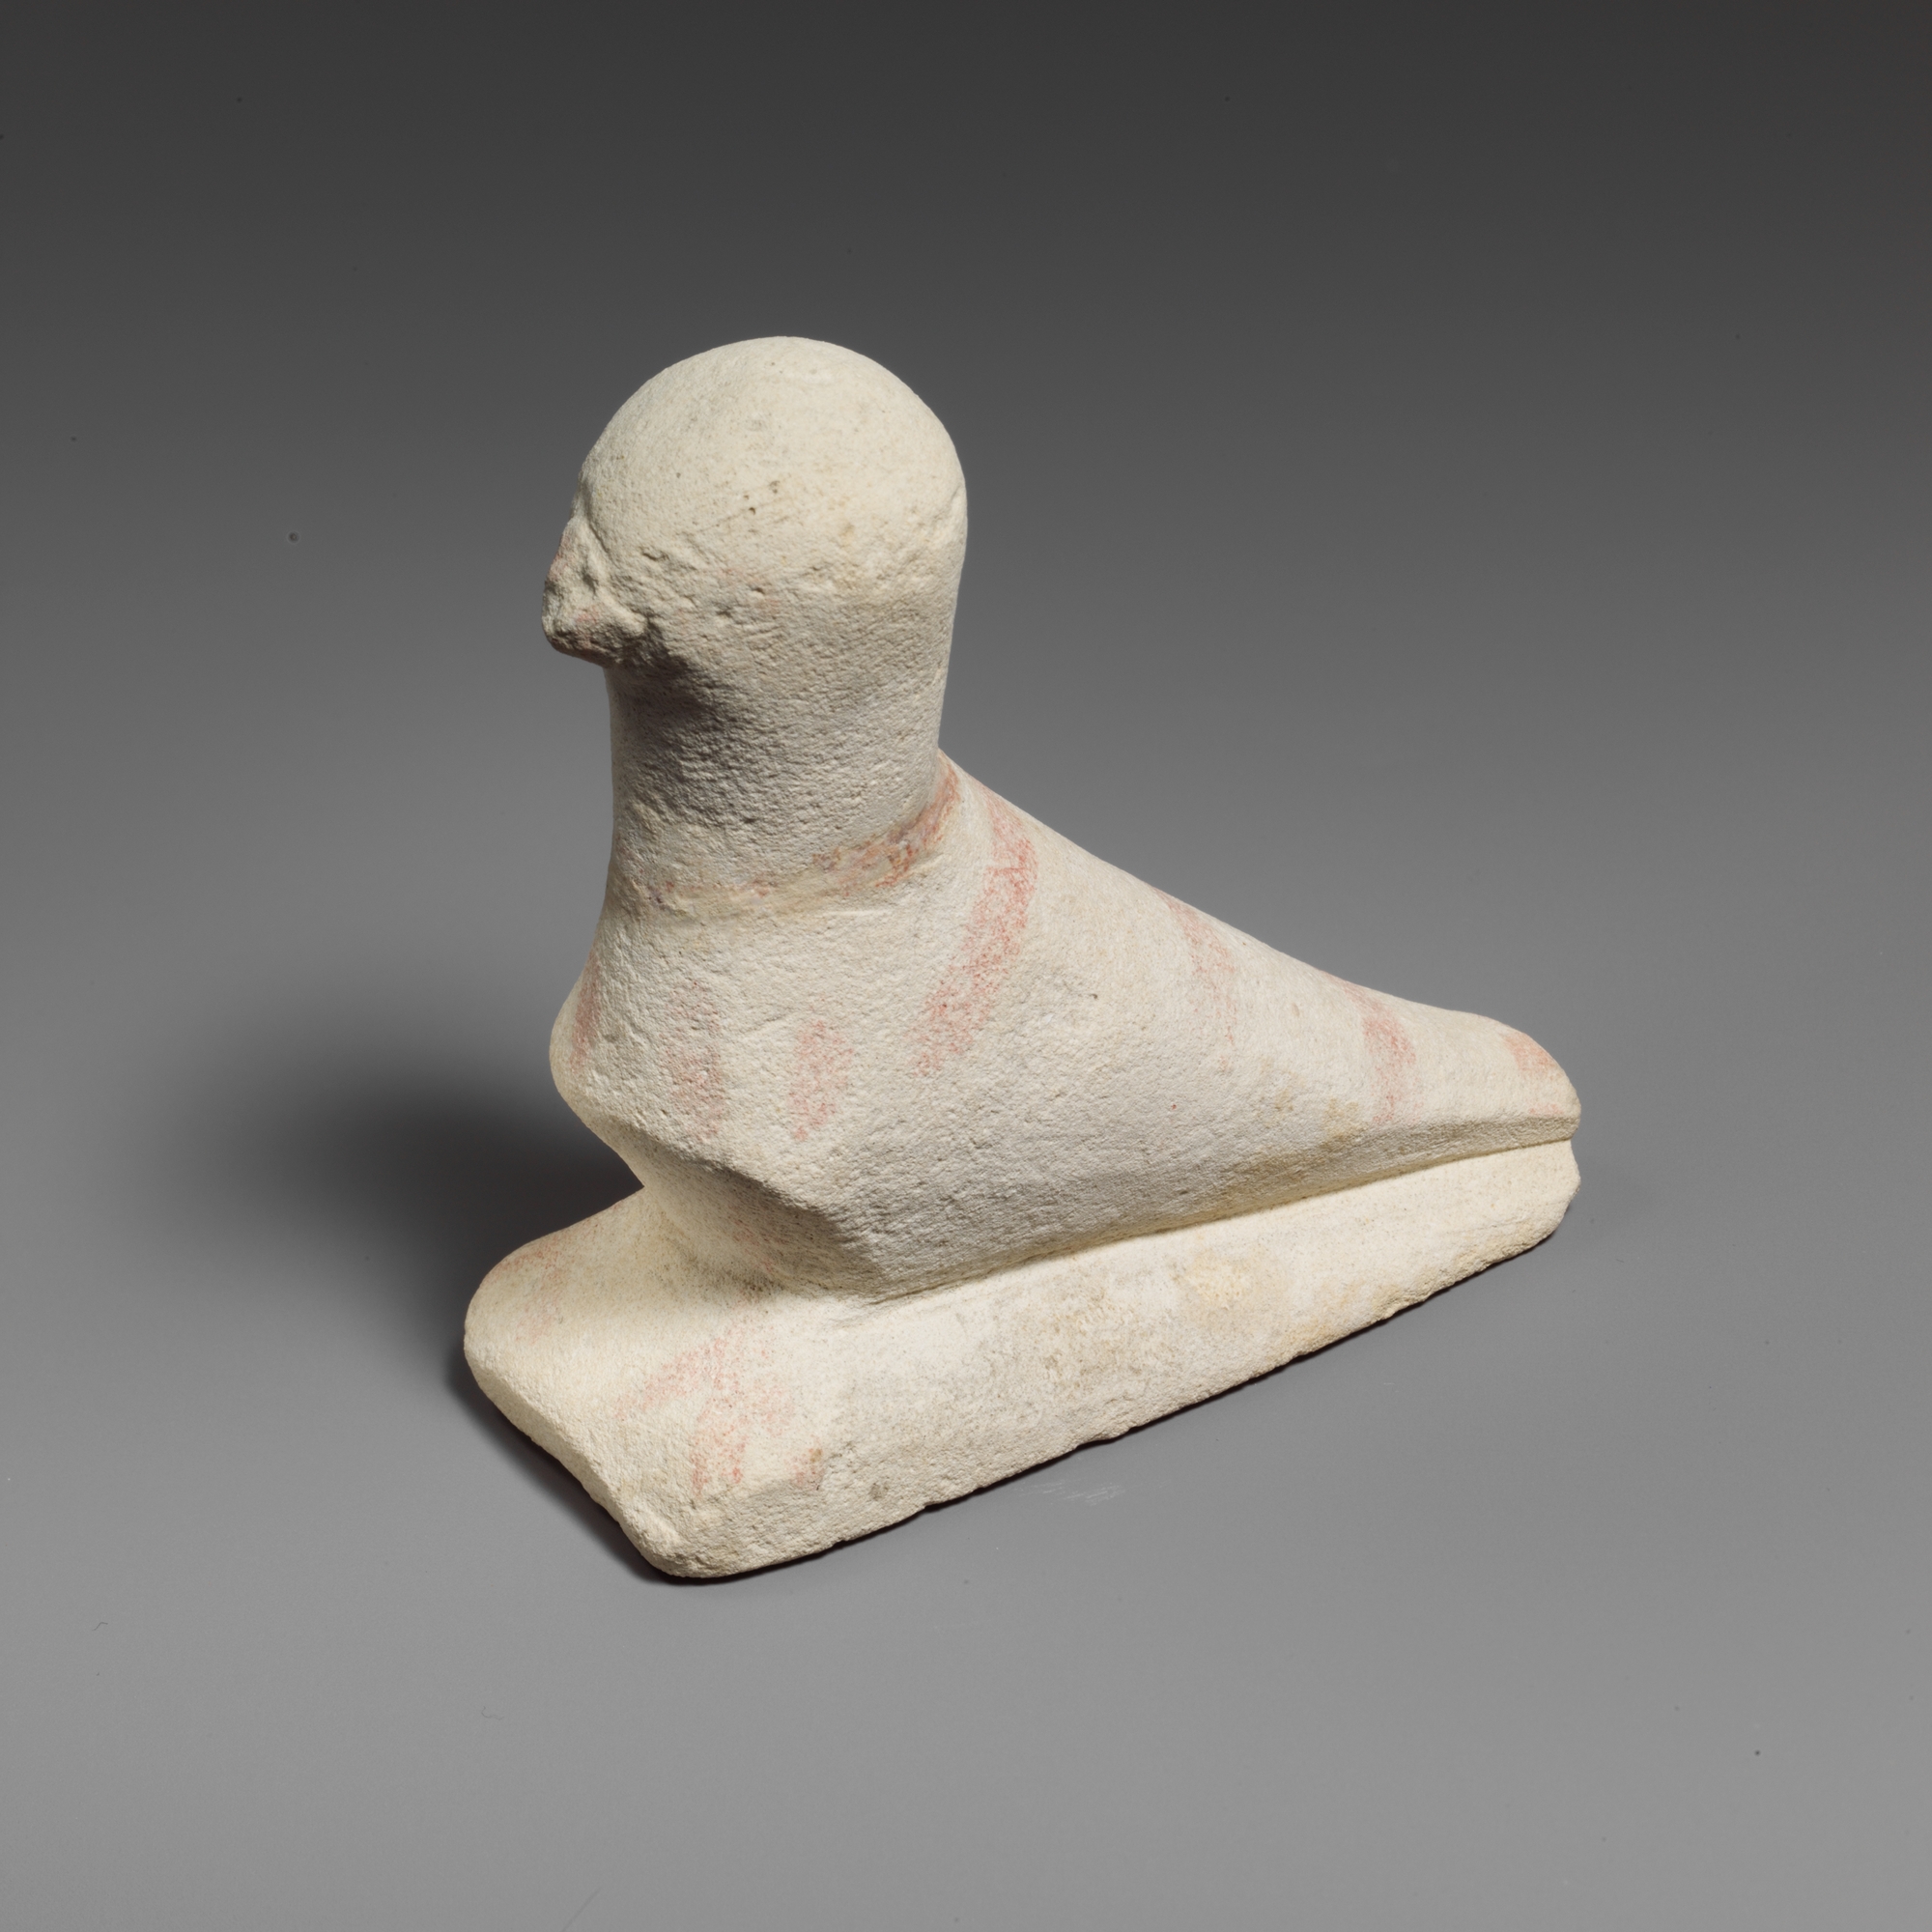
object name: statuette of a bird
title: Limestone statuette of a dove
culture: cypriot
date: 400-301 BCE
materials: limestone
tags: doves